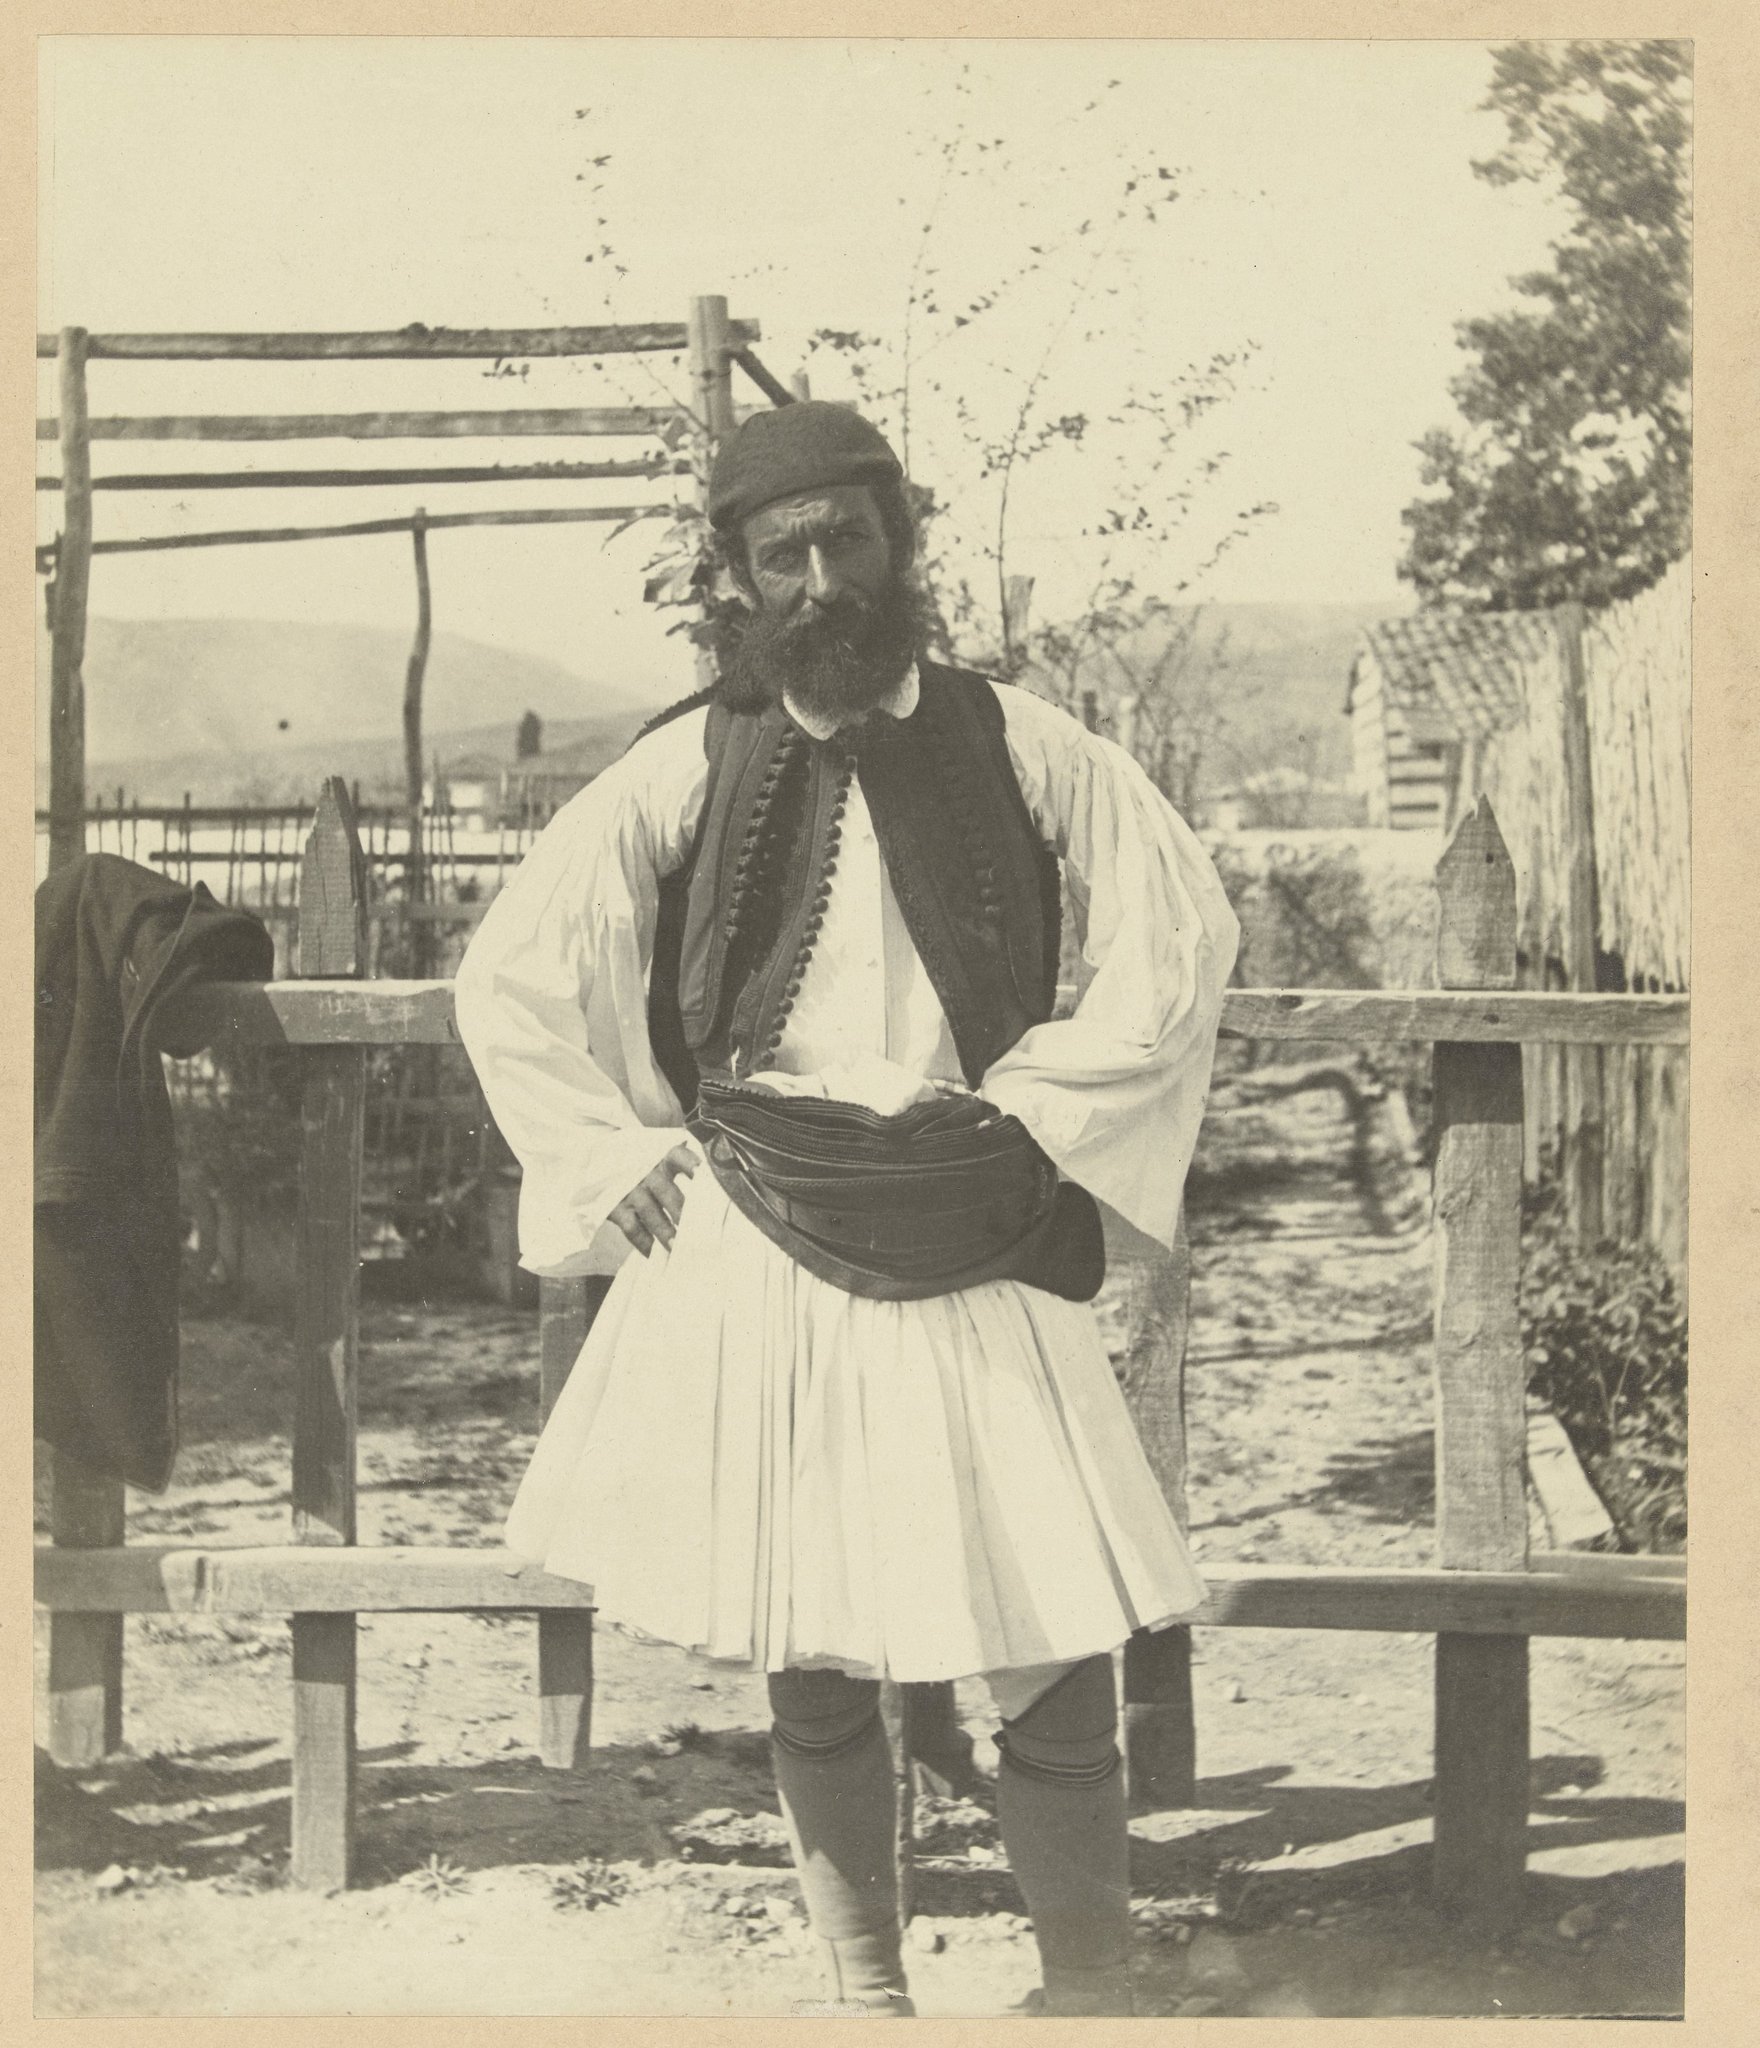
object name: photograph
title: Grieksche landbouwer uit Nauplia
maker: mr. l. de bruyn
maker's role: fotograaf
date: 1900-1910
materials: paper, cardboard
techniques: gelatin silver print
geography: nafplion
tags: farmers, folk costume, regional costume, historical persons not known by name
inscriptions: stamp: ‘Gemeentelijke bibliotheek/ Rotterdam’, inscription: ‘Grieksche landbouwer/ uit Nauplia/ door LDB’, check stamp: ‘Bristol/ L.M.’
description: Onderdeel van een groep door fotograaf Richard Polak op reis verzamelde foto’s. Deze foto is rond 1910 gemaakt door zijn reisgenoot mr. L. de Bruyn. Foto’s die hij op eerdere reizen verzamelde zijn tentoongesteld bij de Rotterdamsche Kunstkring (1895), Arti en Amicitiae te Amsterdam (1897-1898?) en Societeit 't Collegie te Kampen (datum vooralsnog onbekend).